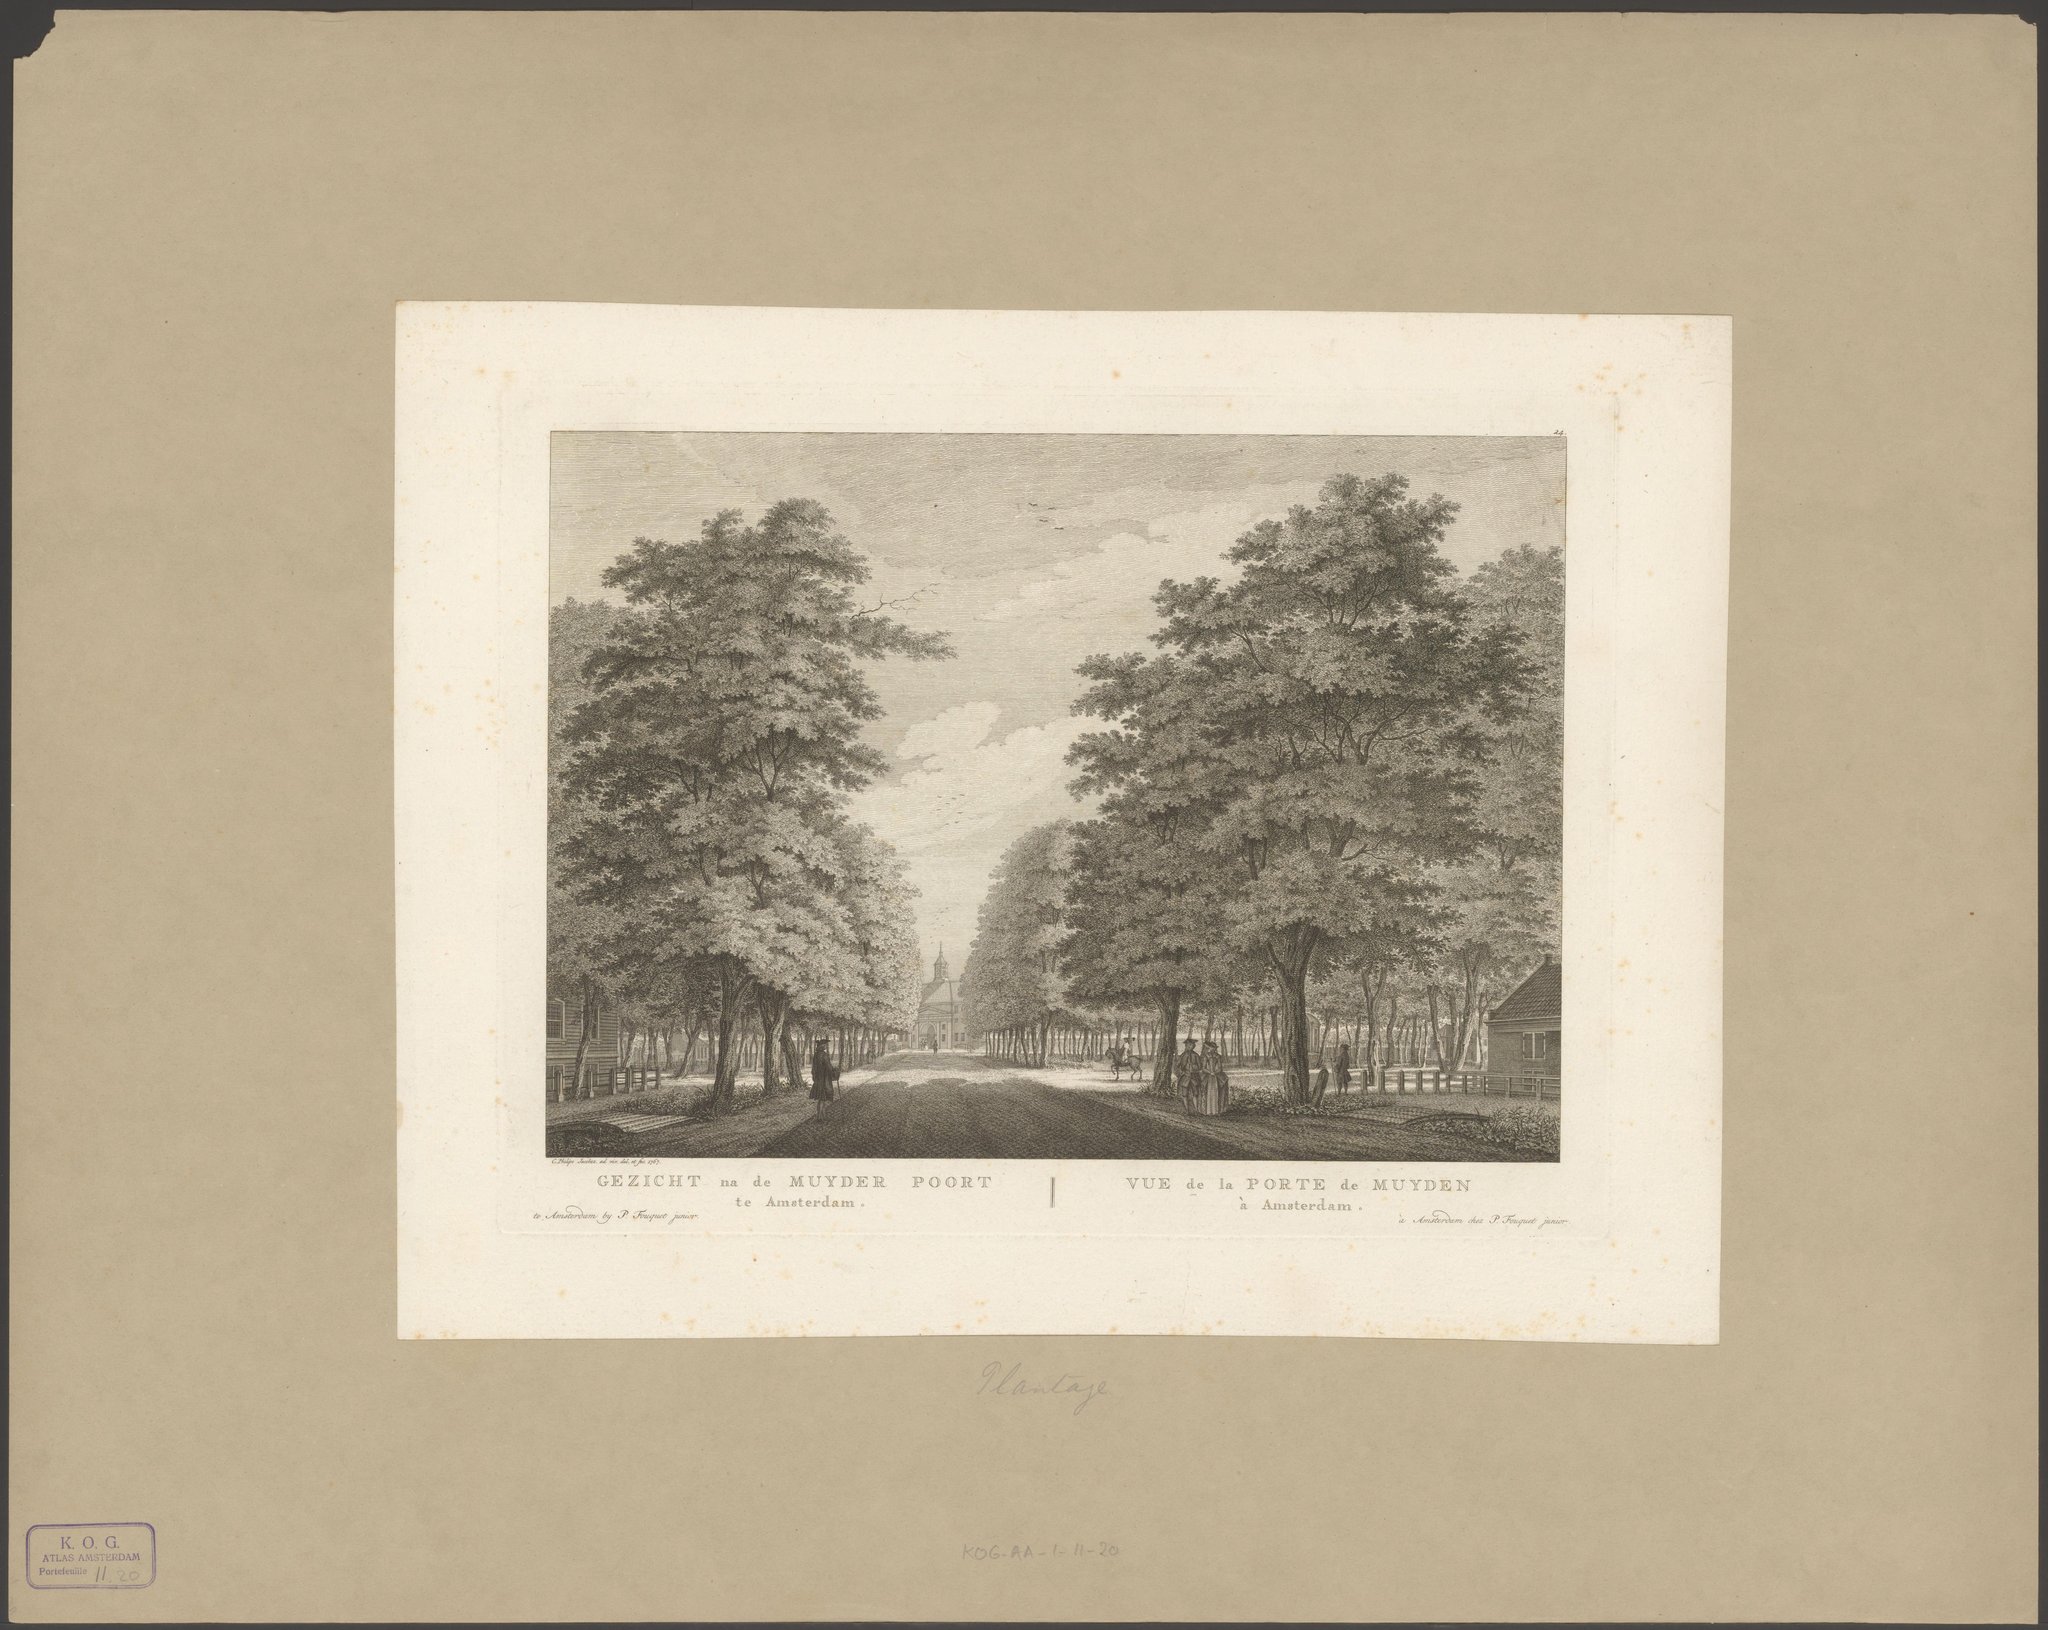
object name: print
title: Gezicht na de Muyder Poort te Amsterdam / Vue de la Porte de Muyden à Amsterdam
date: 1767-1783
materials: paper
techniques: engraving, etching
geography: amsterdam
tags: city-view in general; 'veduta', road, path, city-gate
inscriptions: collector's mark: ‘11.20’ Lugt 1641b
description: Deze prent is ook gebruikt in de zogenaamde Atlas van Fouquet.* Pierre Fouquet gaf vanaf 1760 stadsgezichten van Amsterdam - naar tekeningen van verschillende kunstenaars, gemaakt door verschillende prentmakers - uit. Deze prenten werden aanvankelijk los of in series verkocht. Zoals toen gebruikelijk kon de koper de prenten zelf laten inbinden. Hiertoe gaf Fouquet tussen 1778 en 1783 een titelblad, plattegrond en inhoudsopgave van de tot dusver 100 uitgegeven prenten uit (1). Gezien de inhoud afhankelijk was van wat de koper had verzameld verschilt de inhoud van de verschillende bewaarde Fouquetatlassen onder deze titel sterk. Ook zijn er exemplaren bekend waar tevens andere prenten aan zijn toegevoegd. Omdat er behoefte bleek aan uitleg bij de platen werd in 1783 een nieuwe versie van de atlas uitgegeven, aangevuld met tekst en twee prenten. De aangegeven volgorde veranderde maar de platen van de al eerder uitgegeven prenten bleven ongewijzigd. Deze uitgave werd in opdracht van Fouquet gedrukt bij Daniël Jean Changuion en Petrus den Hengst (2). Een tiental platen werd bijgewerkt en verscheen, met nieuw impressum, in het vervolg van Wagenaars geschiedenis van Amsterdam, uitgeven door Petrus Conradi en Folkert van der Plaats (3). Een aantal jaar na het overlijden van Fouquet kwam Evert Maaskamp met een nieuwe uitgave van de atlas, met verbeterde tekst en toevoeging van twee prenten. Op alle platen verwijderde hij het oude en liet hij zijn eigen impressum zetten (4). De huidige staat van de prent komt voor in exemplaren van de onder (1) en (2) genoemde werken. * Onder de Atlas van Fouquet of Fouquetatlas verstaan we de hieronder vermelde publicaties (1), (2) en (4). (1). Afbeeldingen van de wyd-vermaarde koopstad Amsterdam benevens des zelvs voornaamste gebouwen en gezigten alle naar het leeven getekend / Receuil des edifices les plus considerables et des plus belles vues, de la fameuse ville d'Amsterdam, dessinées d'après nature. Amsterdam: Pierre Fouquet, 1778-1783. (2). Nieuwe atlas, van de voornaamste gebouwen en gezigten der stad Amsterdam, met derzelver beknopte beschryvingen. 2 delen. Amsterdam: Daniël Jean Changuion en Petrus den Hengst [in opdracht van Pierre Fouquet], 1783. (3). Stijl, Simon. Amsterdam, in zyne geschiedenissen, voorregten, koophandel, gebouwen, kerkenstaat, schoolen, schutterye, gilden en regeeringe, beschreeven. Om te dienen ten vervolge op het werk van Jan Wagenaar (…). 10 delen. Amsterdam en Harlingen: Petrus Conradi en Folkert van der Plaats, 1788-1801. (4). Nieuwe atlas, van de voornaamste gebouwen en gezigten der stad Amsterdam. Met derzelver beknopte beschryvingen. Amsterdam: Evert Maaskamp, 1805. * Het aantal vermelde staten is gebaseerd op het aantal gevonden staten. Mogelijk zijn er meer staten van deze prent.